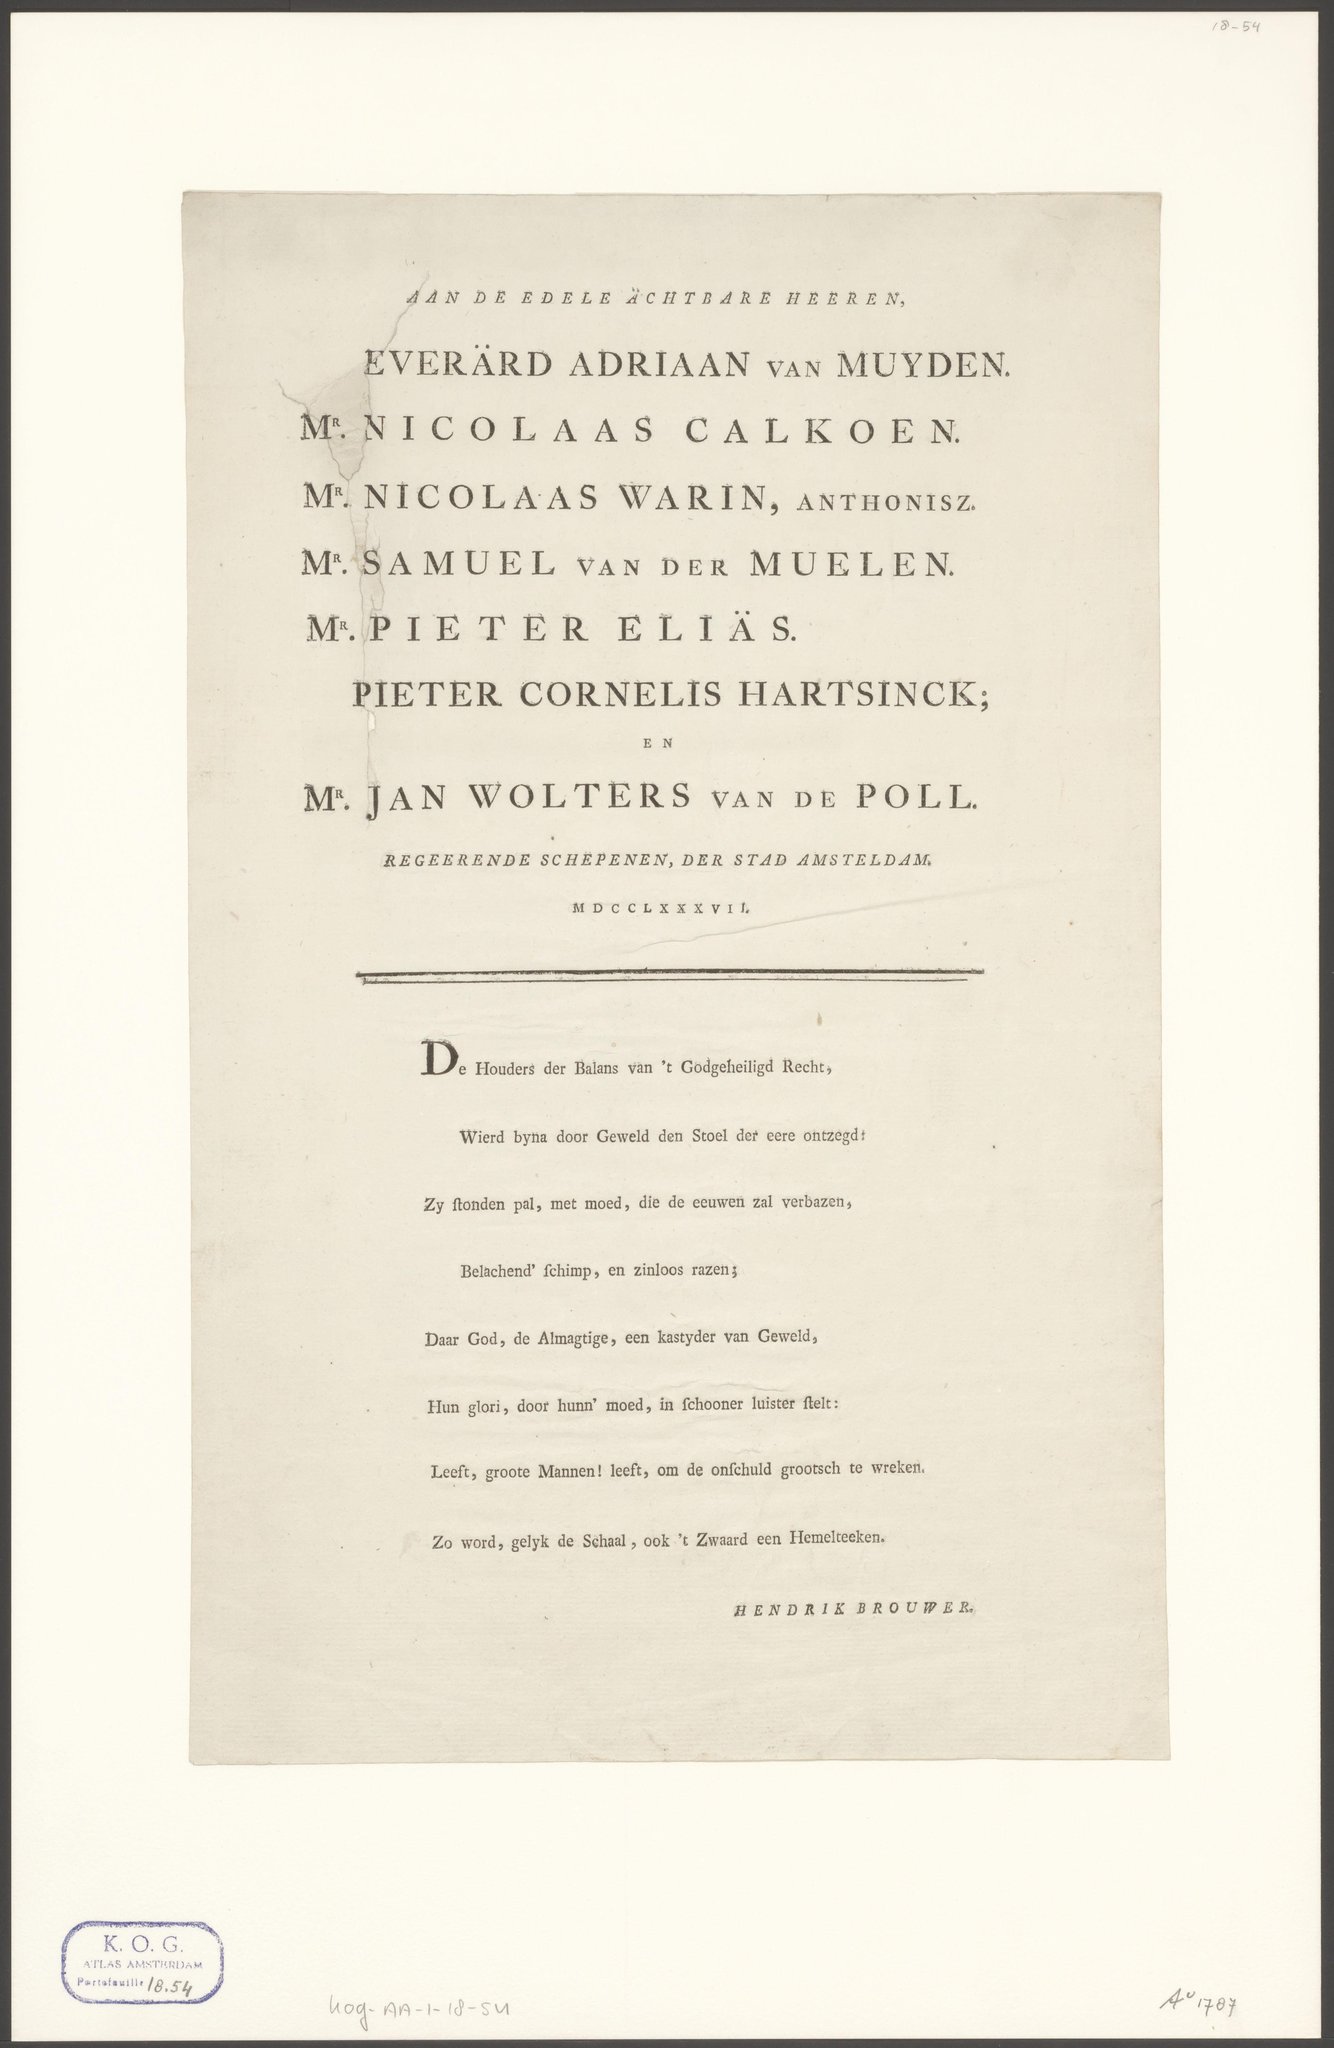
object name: text sheet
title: Lofdicht op de regerende schepenen in 1787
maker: Anonymous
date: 1787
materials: paper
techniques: letterpress printing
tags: municipal government, amsterdam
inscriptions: name: ‘Hendrik Brouwer’, collector's mark: ‘18.54’ Lugt 1641b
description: Onderwerpsrubriek binnen de Atlas Amsterdam: Herinneringen aan regeringsleden en hunne huisgezinnen [voor 1800].